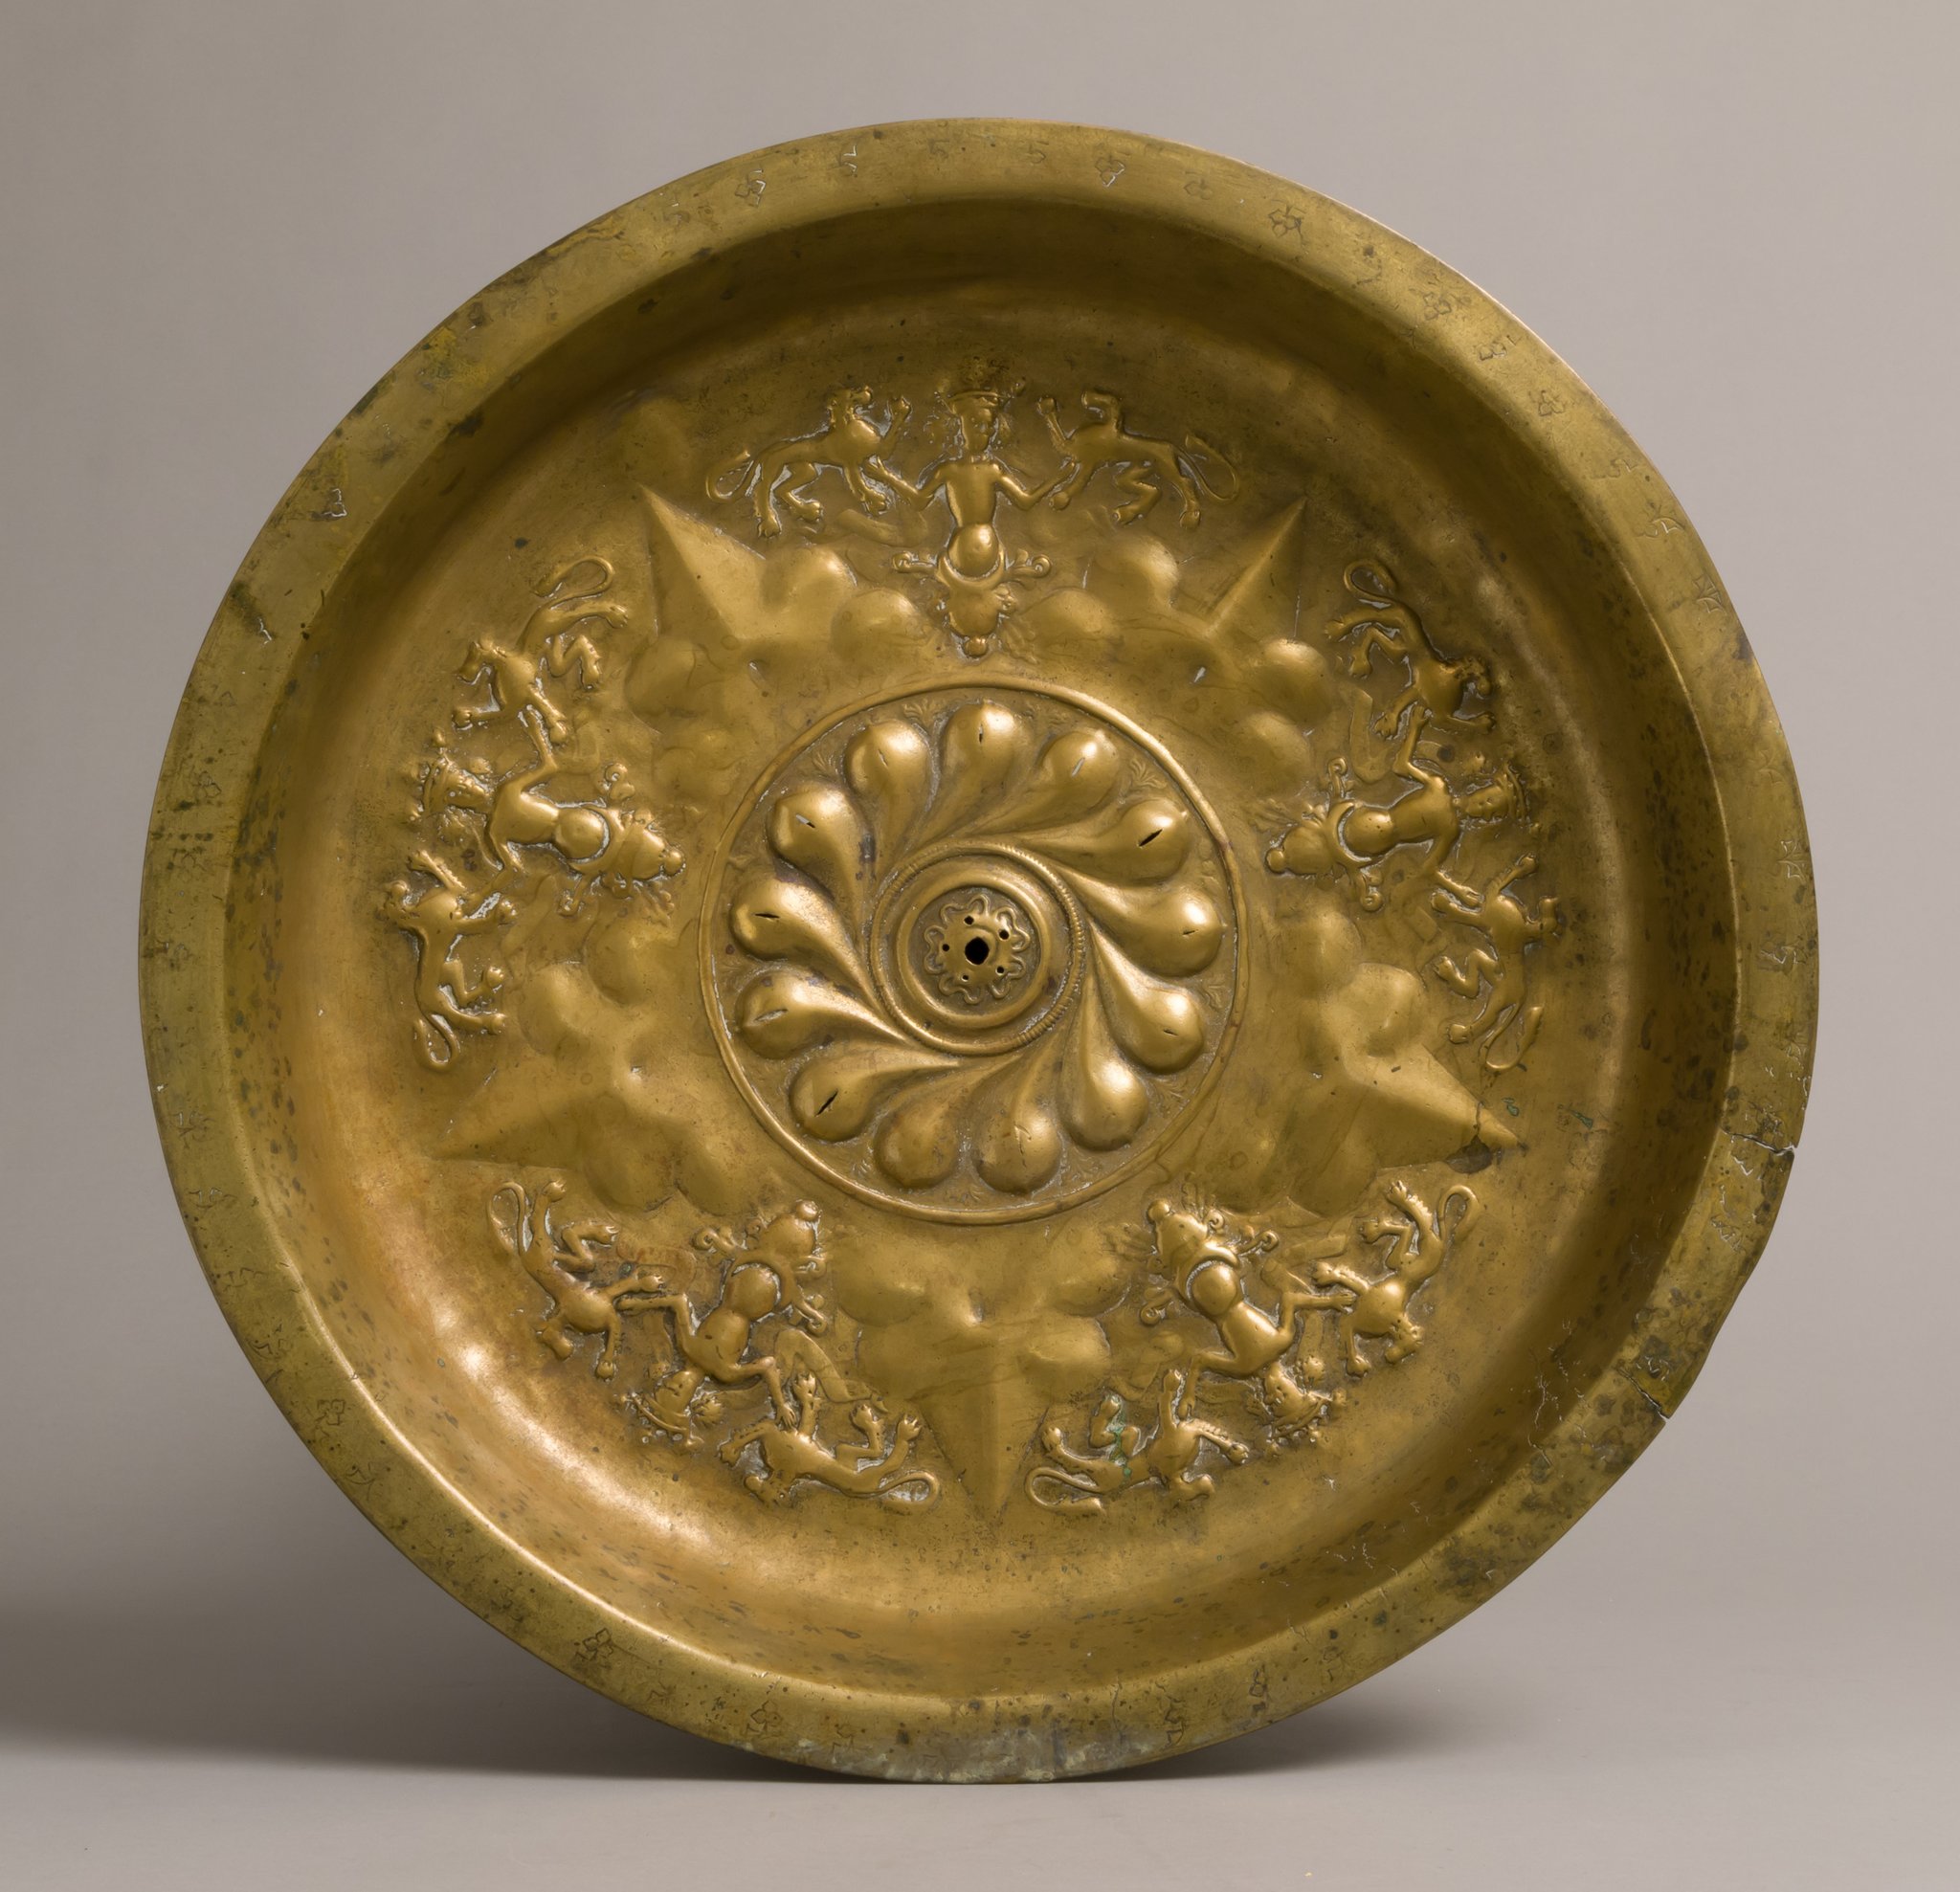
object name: plate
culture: german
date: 1467-1500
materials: brass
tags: animals